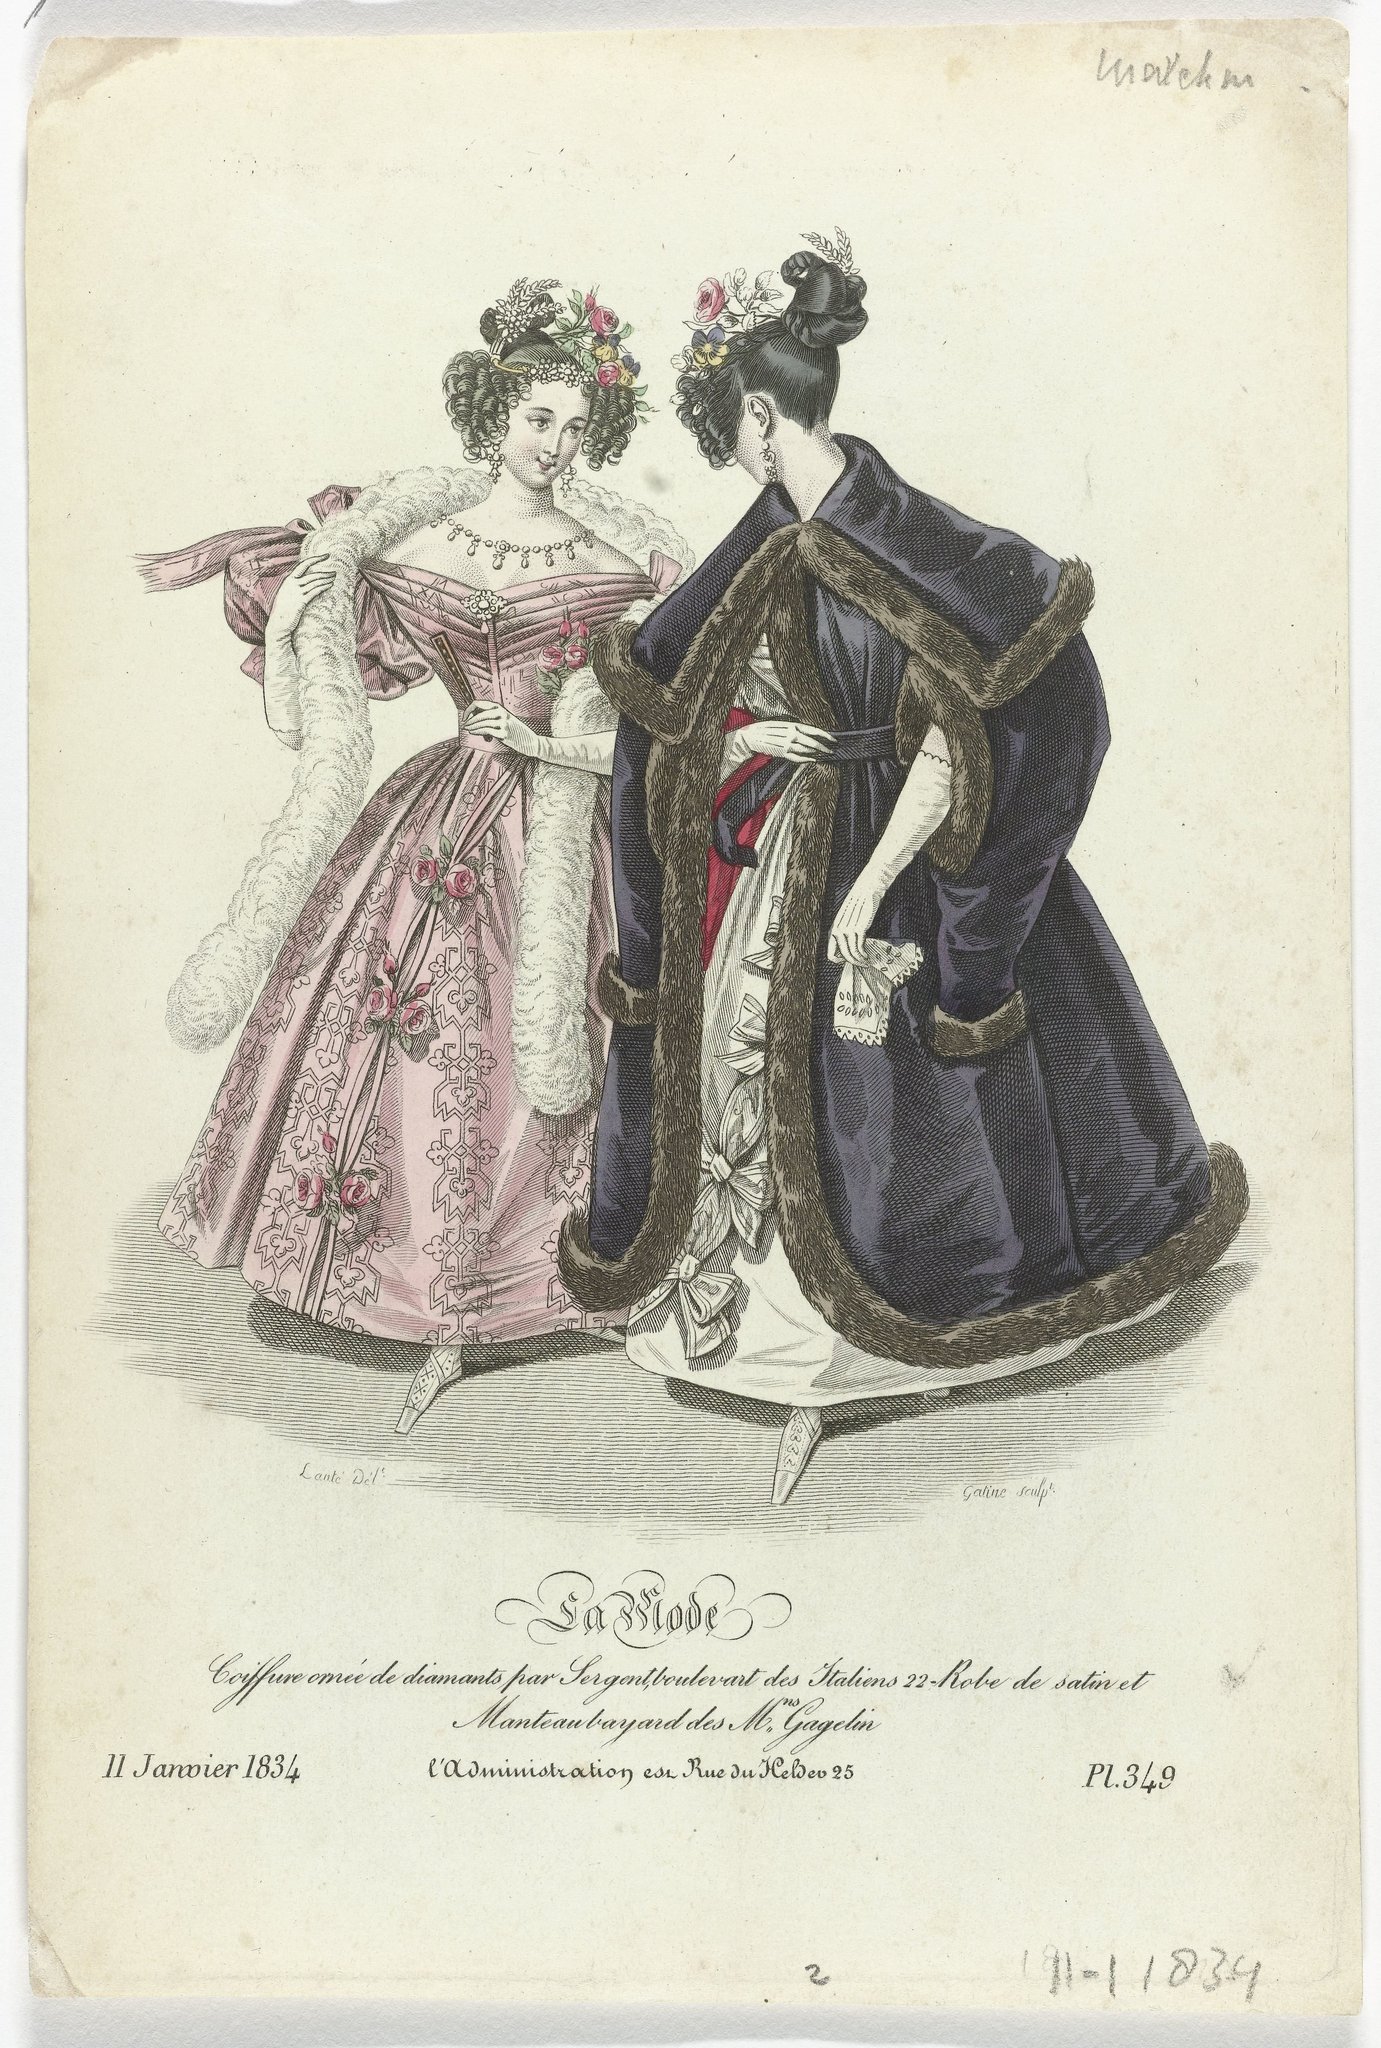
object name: fashion print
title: La Mode, 11 Janvier 1834, Pl. 349 : Coiffure ornée de diamants (...)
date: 1834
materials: paper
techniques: engraving, hand coloring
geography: paris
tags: flowers, ear-rings (+ women's clothes), handkerchief (+ women's clothes), brooch, agraffe, clasp (+ women's clothes), coat (+ women's clothes), styles of hairdress - aa - ~ women, fashion plates, dress, gown (+ women's clothes), clothing for the upper part of the body (shawl) (+ fur used for clothes), fan (+ women's clothes), necklace (+ women's clothes)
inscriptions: caption: ‘Coiffure ornée de diamants par Sergent, boulevart des Italiens 22 - Robe de satin et Manteau bayard des M.ns Gagelin’, title: ‘La Mode’, address: ‘L'Administration est Rue du Helder 25’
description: 'Coiffure' versierd met diamanten van Sergent. Japon van satijn versierd met bloemcorsages. Accessoires: oorbellen, collier, broche, stola, waaier, lange handschoenen. Mantel afgezet met bont of 'Manteau bayard uit de winkels van Gagelin. Schouderkraag. Retro-mouwen met splitten die tevens als armsgaten dienen. Prent uit het modetijdschrift La Mode (1829-1855). De prent is een kopie naar Nr. 3139, 31 décembre 1833, uit het modetijdschrift Journal des Dames et des Modes.